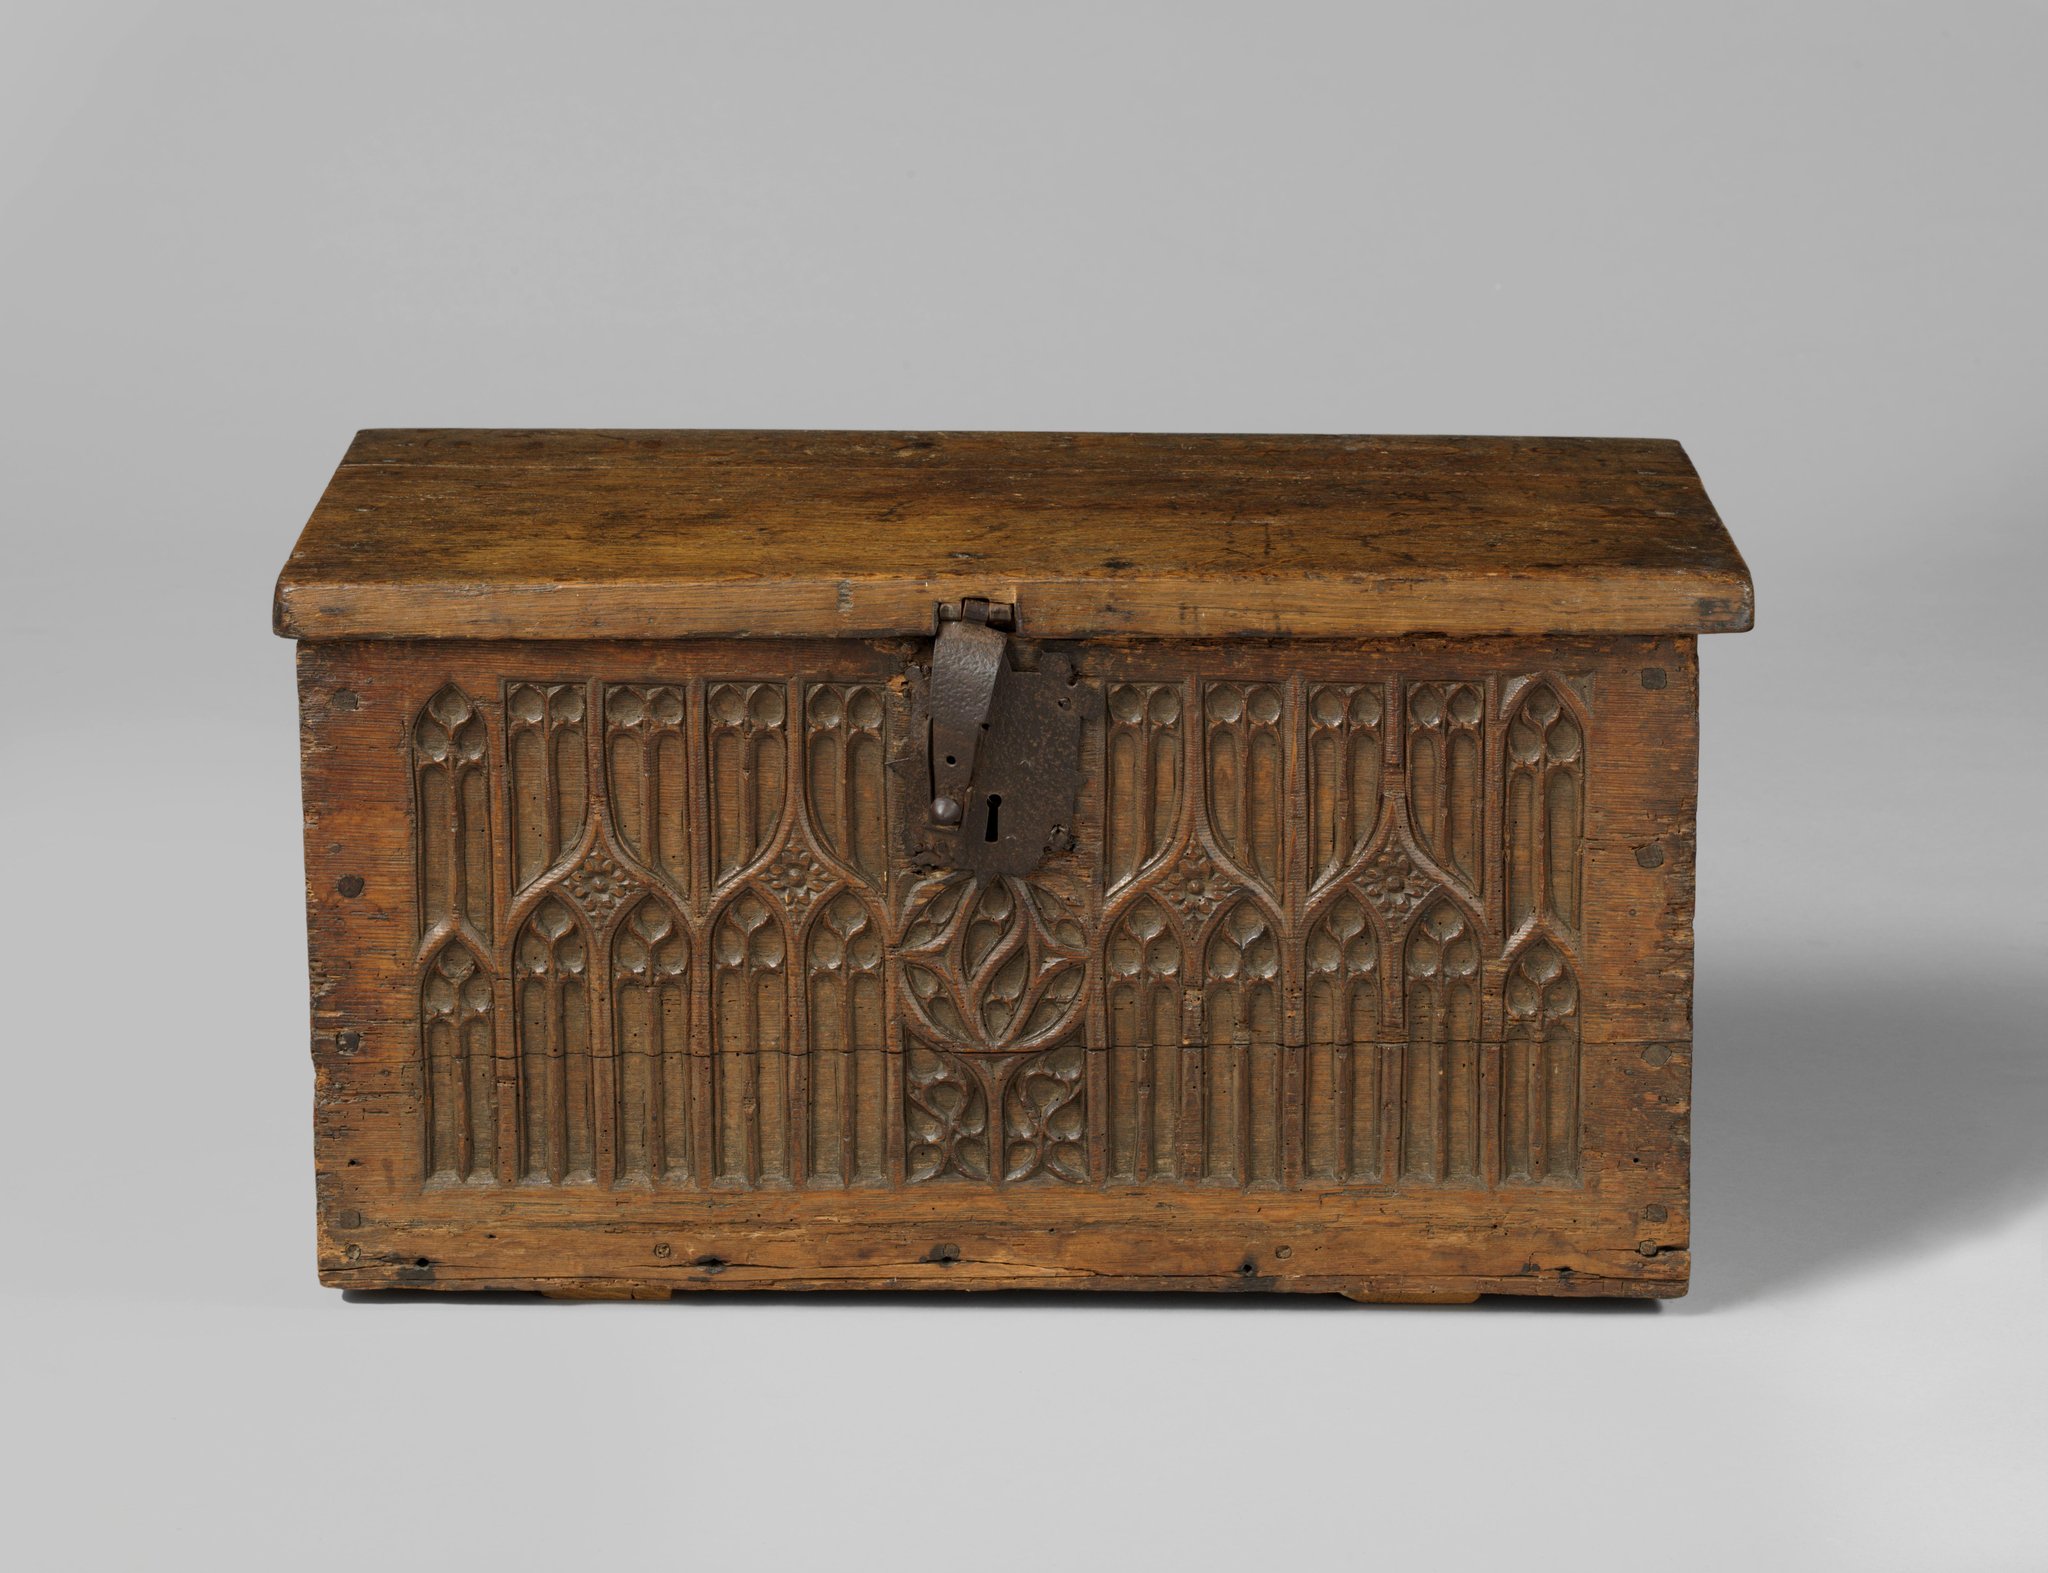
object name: case furniture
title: Kist waarvan het voorbord is versierd met Gotische traceringen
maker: Anonymous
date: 1500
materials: iron, wood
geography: netherlands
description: Chest. Oak. Netherlands, c. 1500.